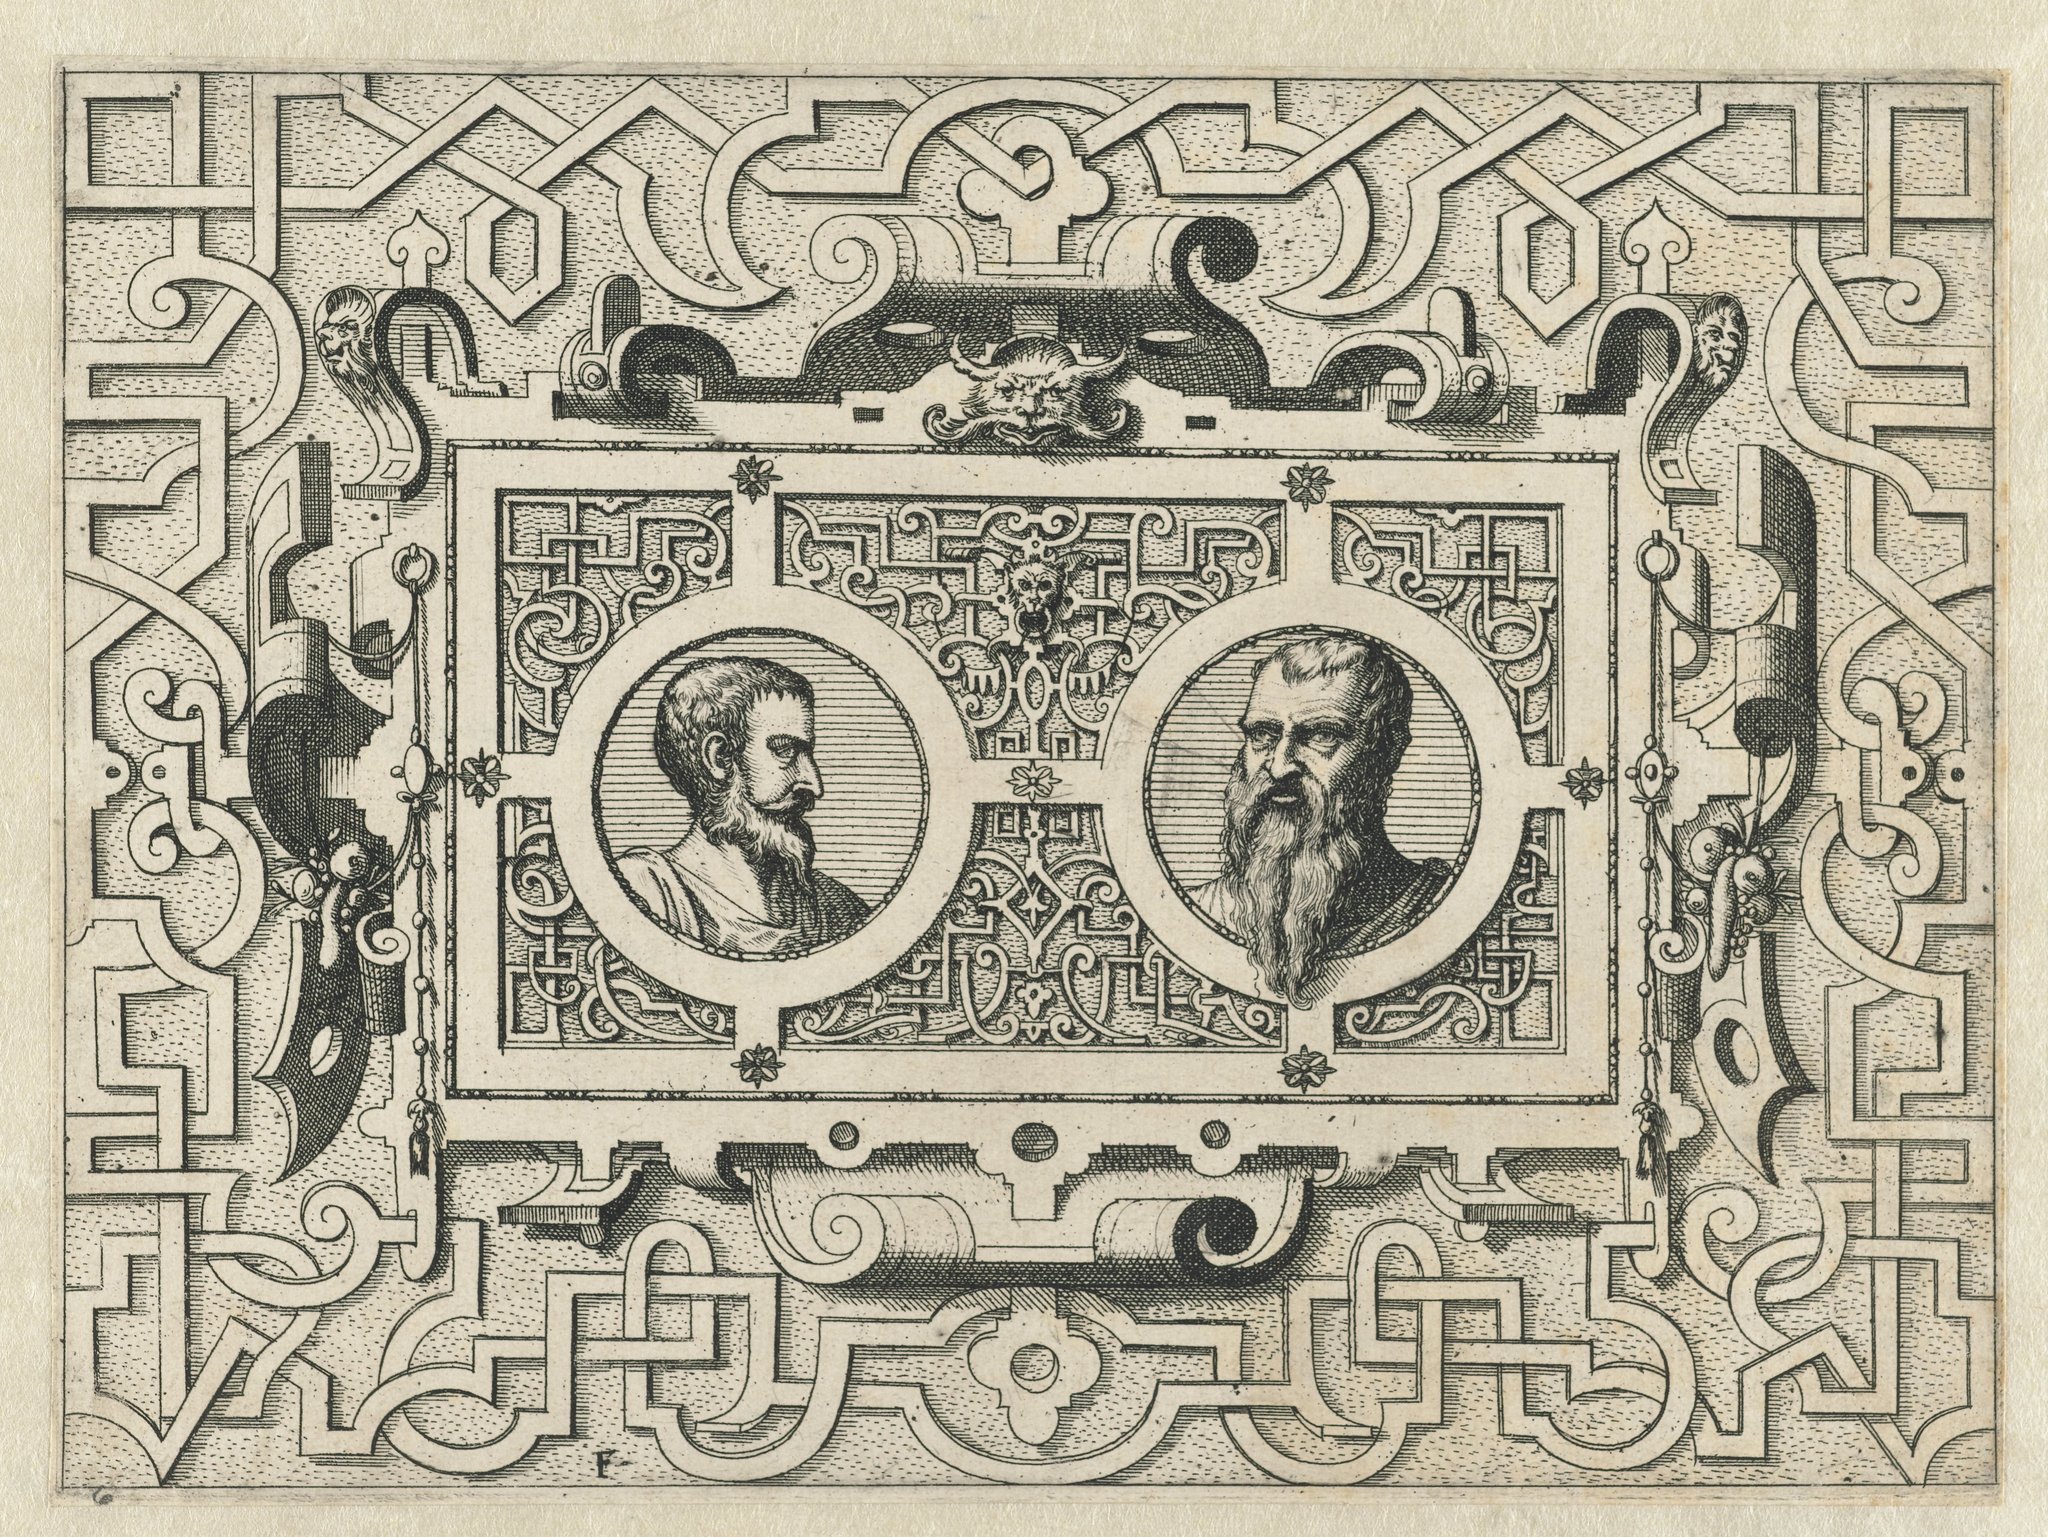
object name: ornament print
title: Cartouche omgeven door moresken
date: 1555-1560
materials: paper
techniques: etching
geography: netherlands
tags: ornament ~ moresque, ornament ~ cartouche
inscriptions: inscription: ‘.’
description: Gestippelde achtergrond. In de cartouche bevinden zich twee medaillons met mansportretten. Blad F uit serie van 16 bladen, geletterd A-Q. Gearceerde of gestippelde achtergrond.